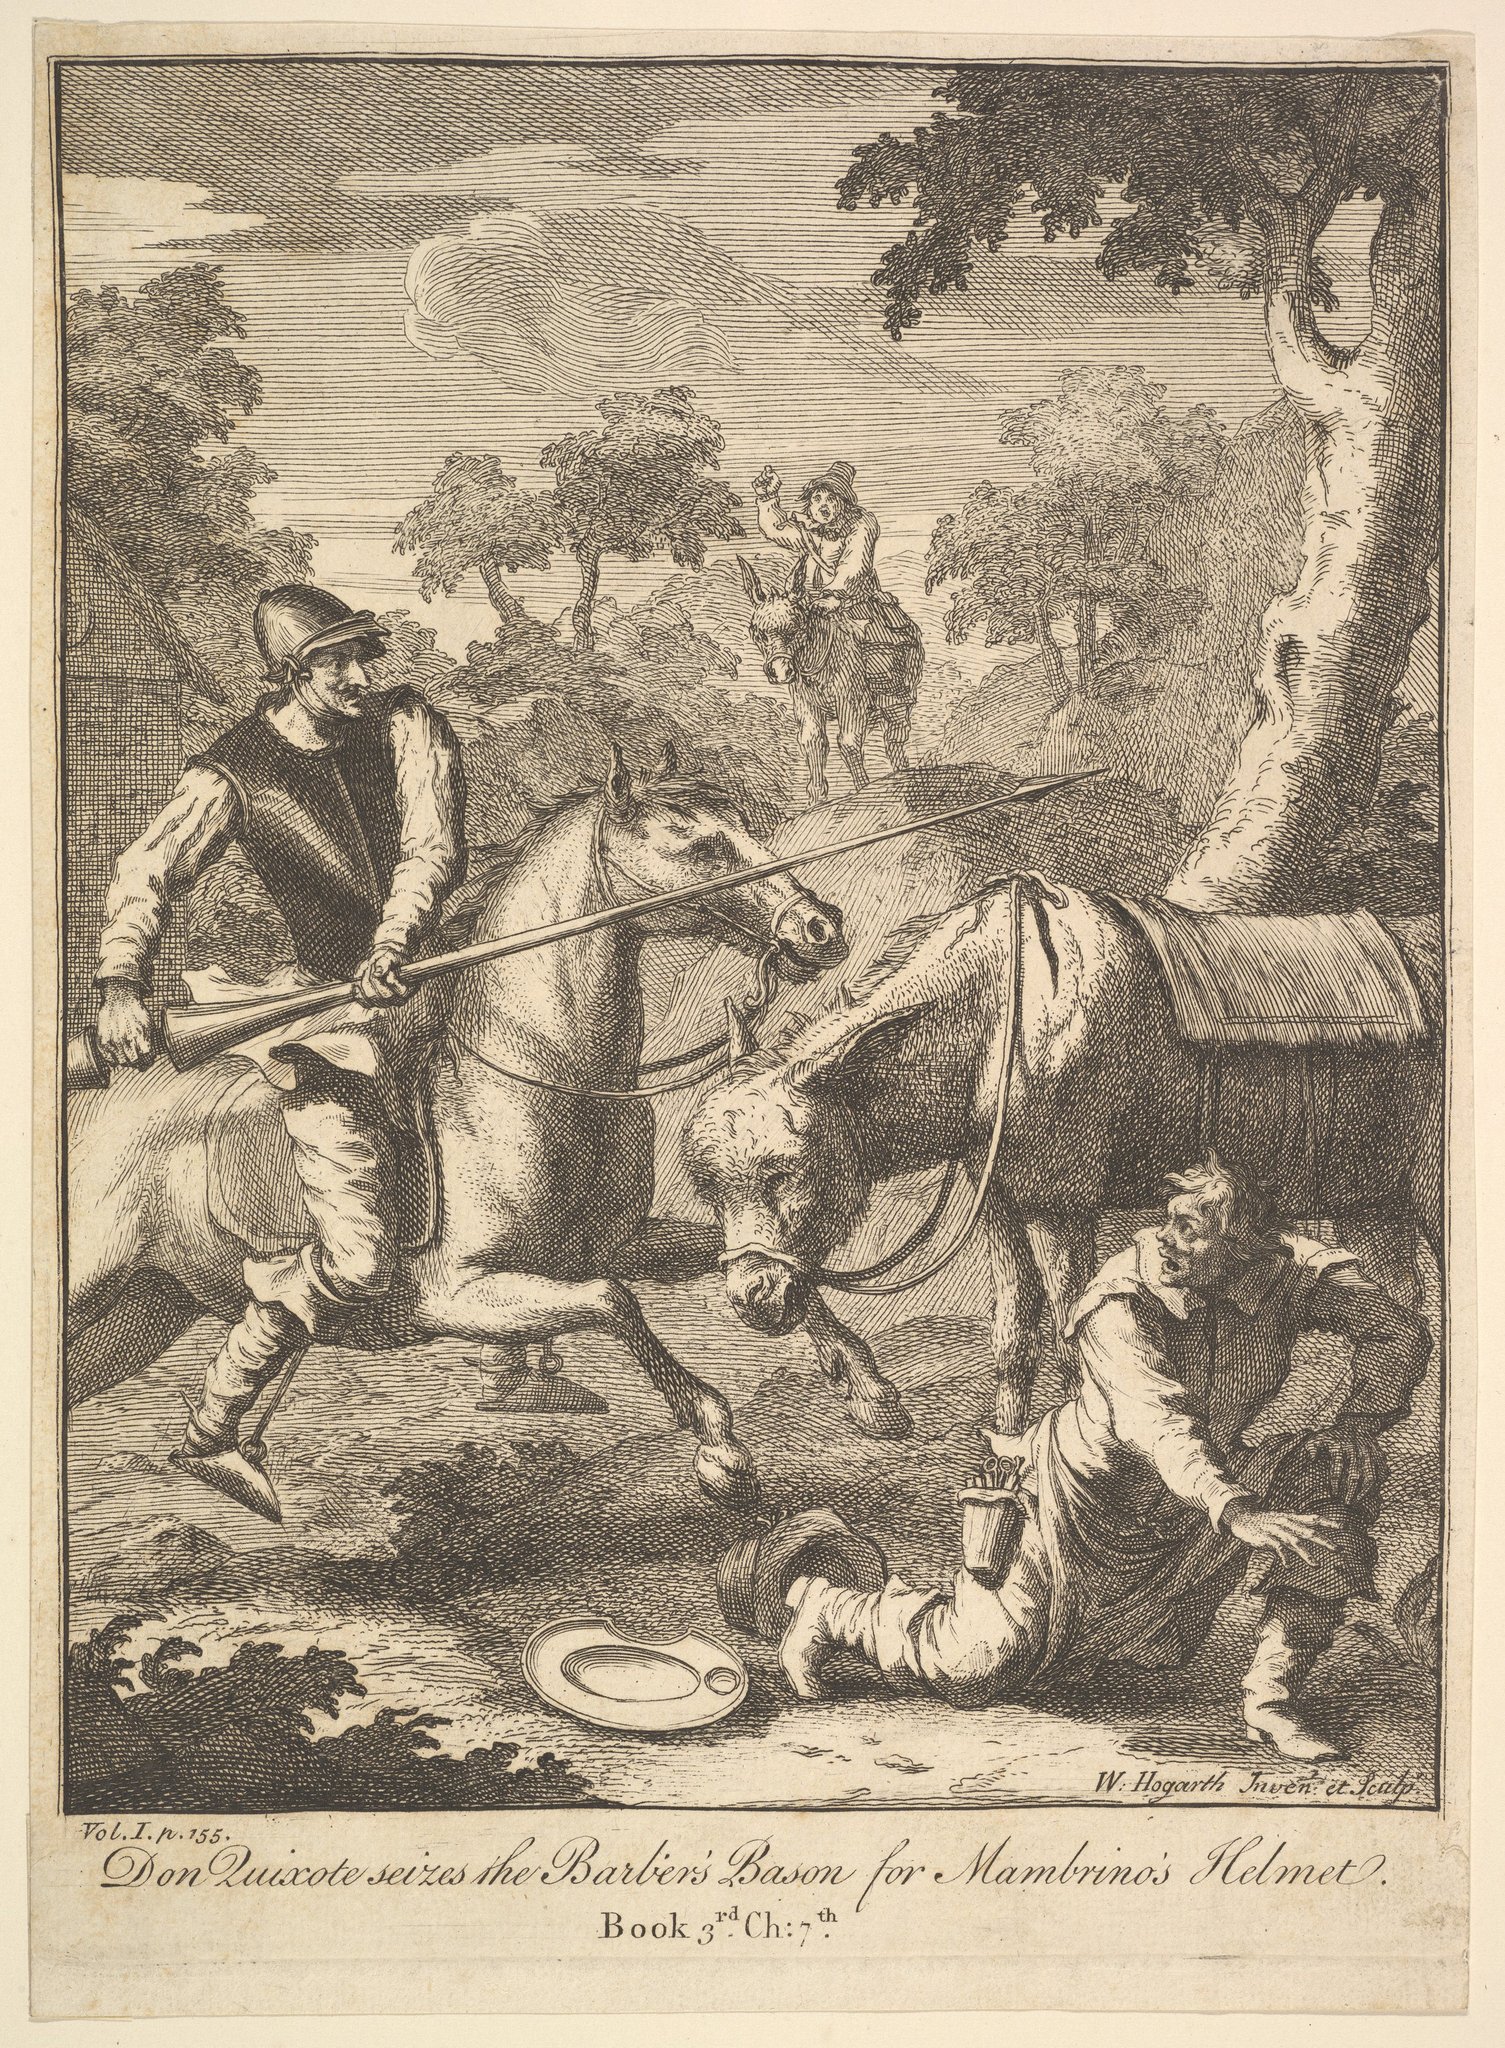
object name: print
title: The Adventure of Mambrino's Helmet (Six Illustrations for Don Quixote)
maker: william hogarth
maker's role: artist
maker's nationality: british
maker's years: 1697-1764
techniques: engraving, etching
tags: men,donkeys,horses,don quixote